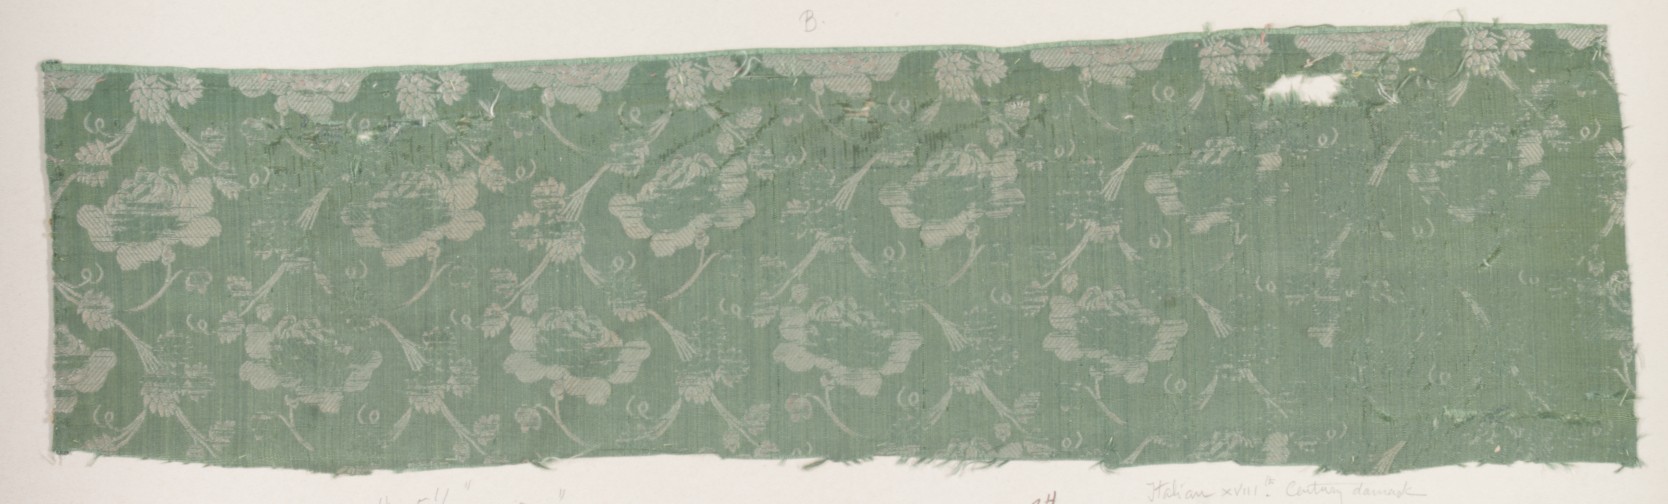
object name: fragment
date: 1701-1800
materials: silk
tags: flowers